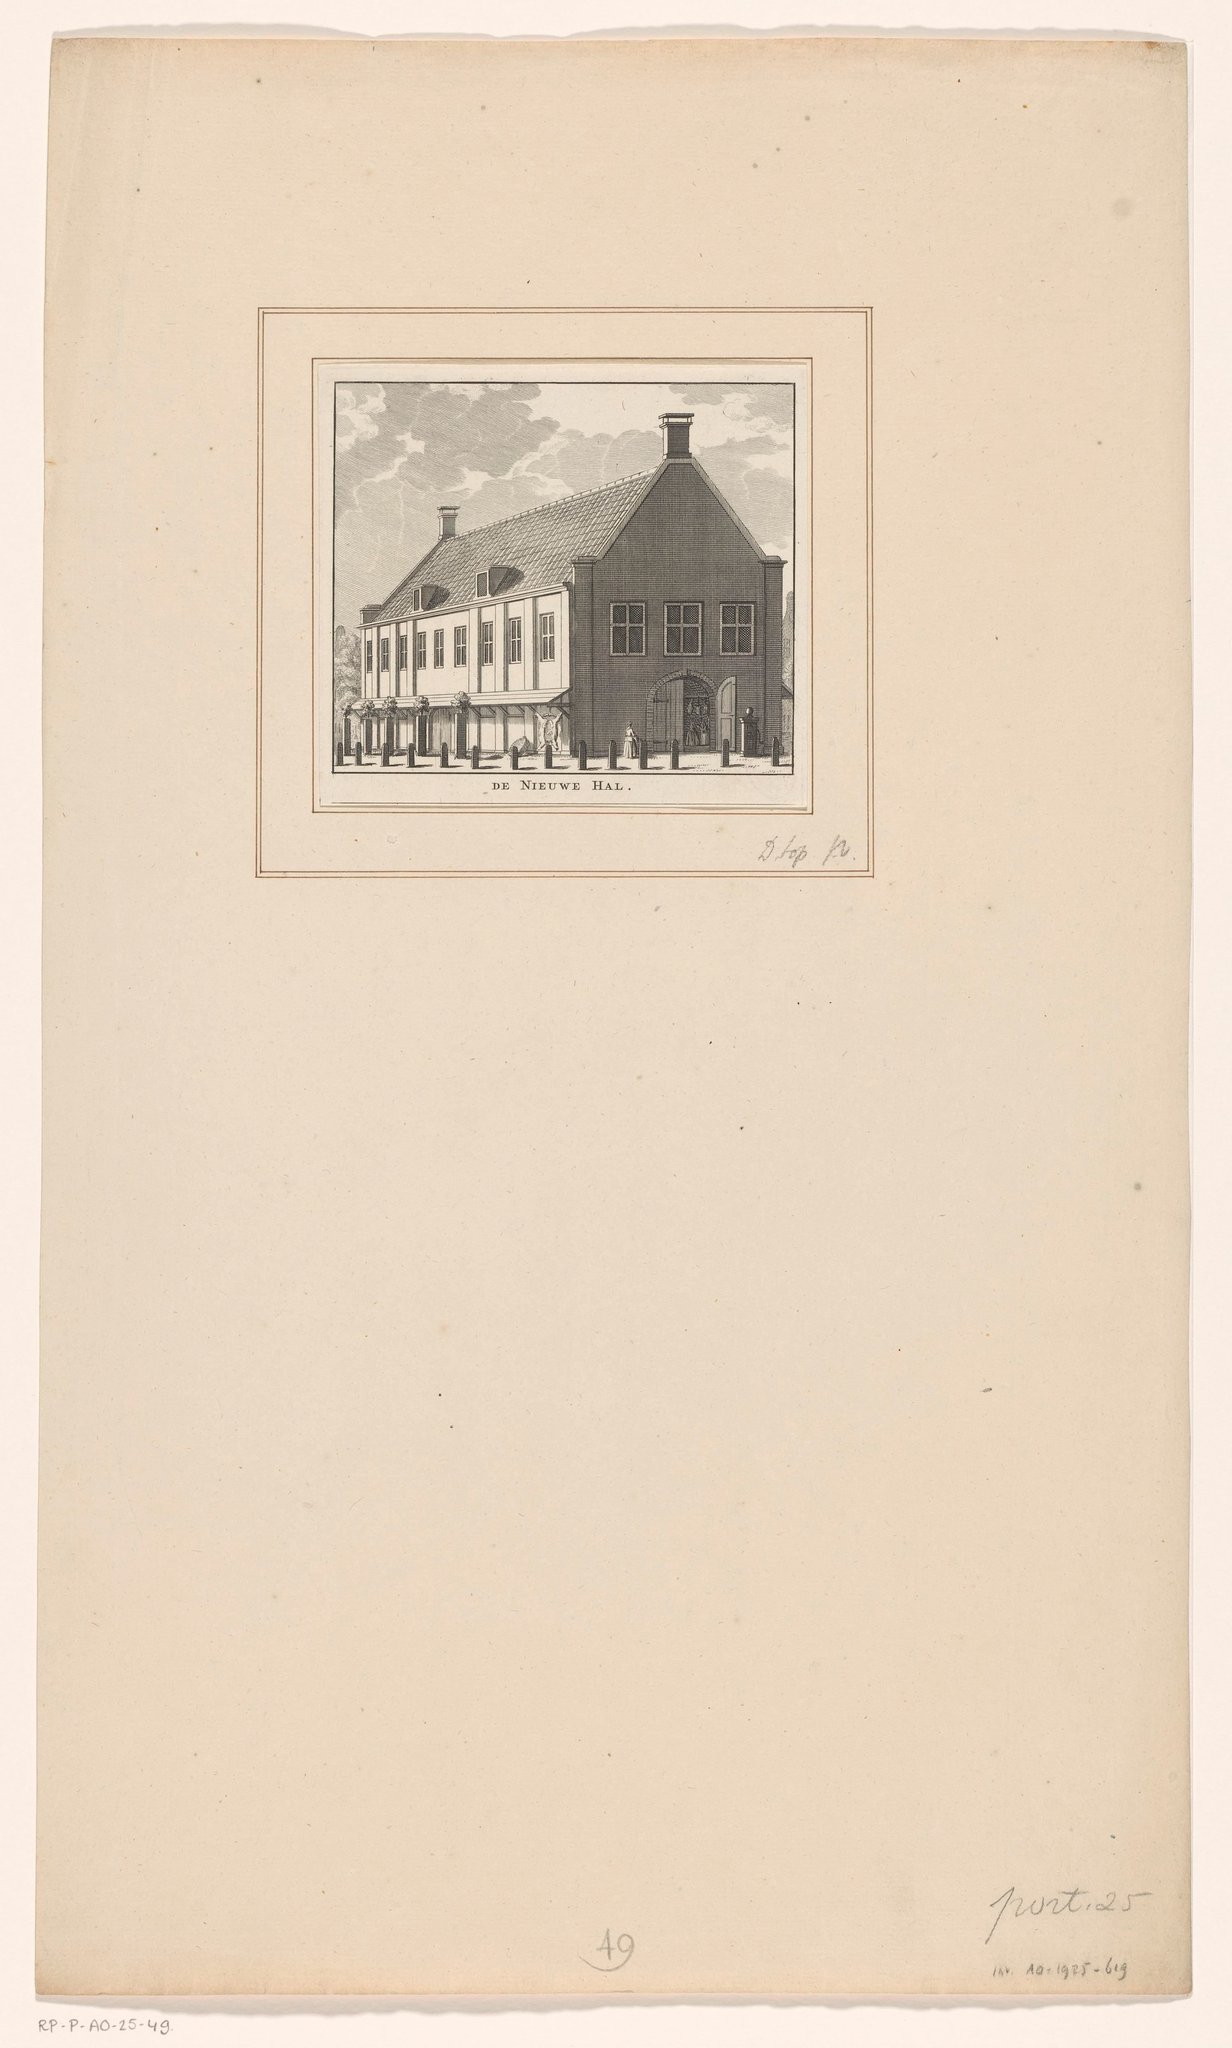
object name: print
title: De Nieuwe Hal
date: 1765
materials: paper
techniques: engraving, etching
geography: amsterdam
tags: market-hall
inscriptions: collector's mark: Lugt 2228, collector's mark: Lugt 195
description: Prent ook gebruikt in: Wagenaar, Jan. Amsterdam, in zyne opkomst, aanwas, geschiedenissen (…). 3 delen [folio-uitgave]. Amsterdam: Isaak Tirion en Yntema & Tieboel, 1760-1767, dl. 2 (Isaac Tirion, 1765).